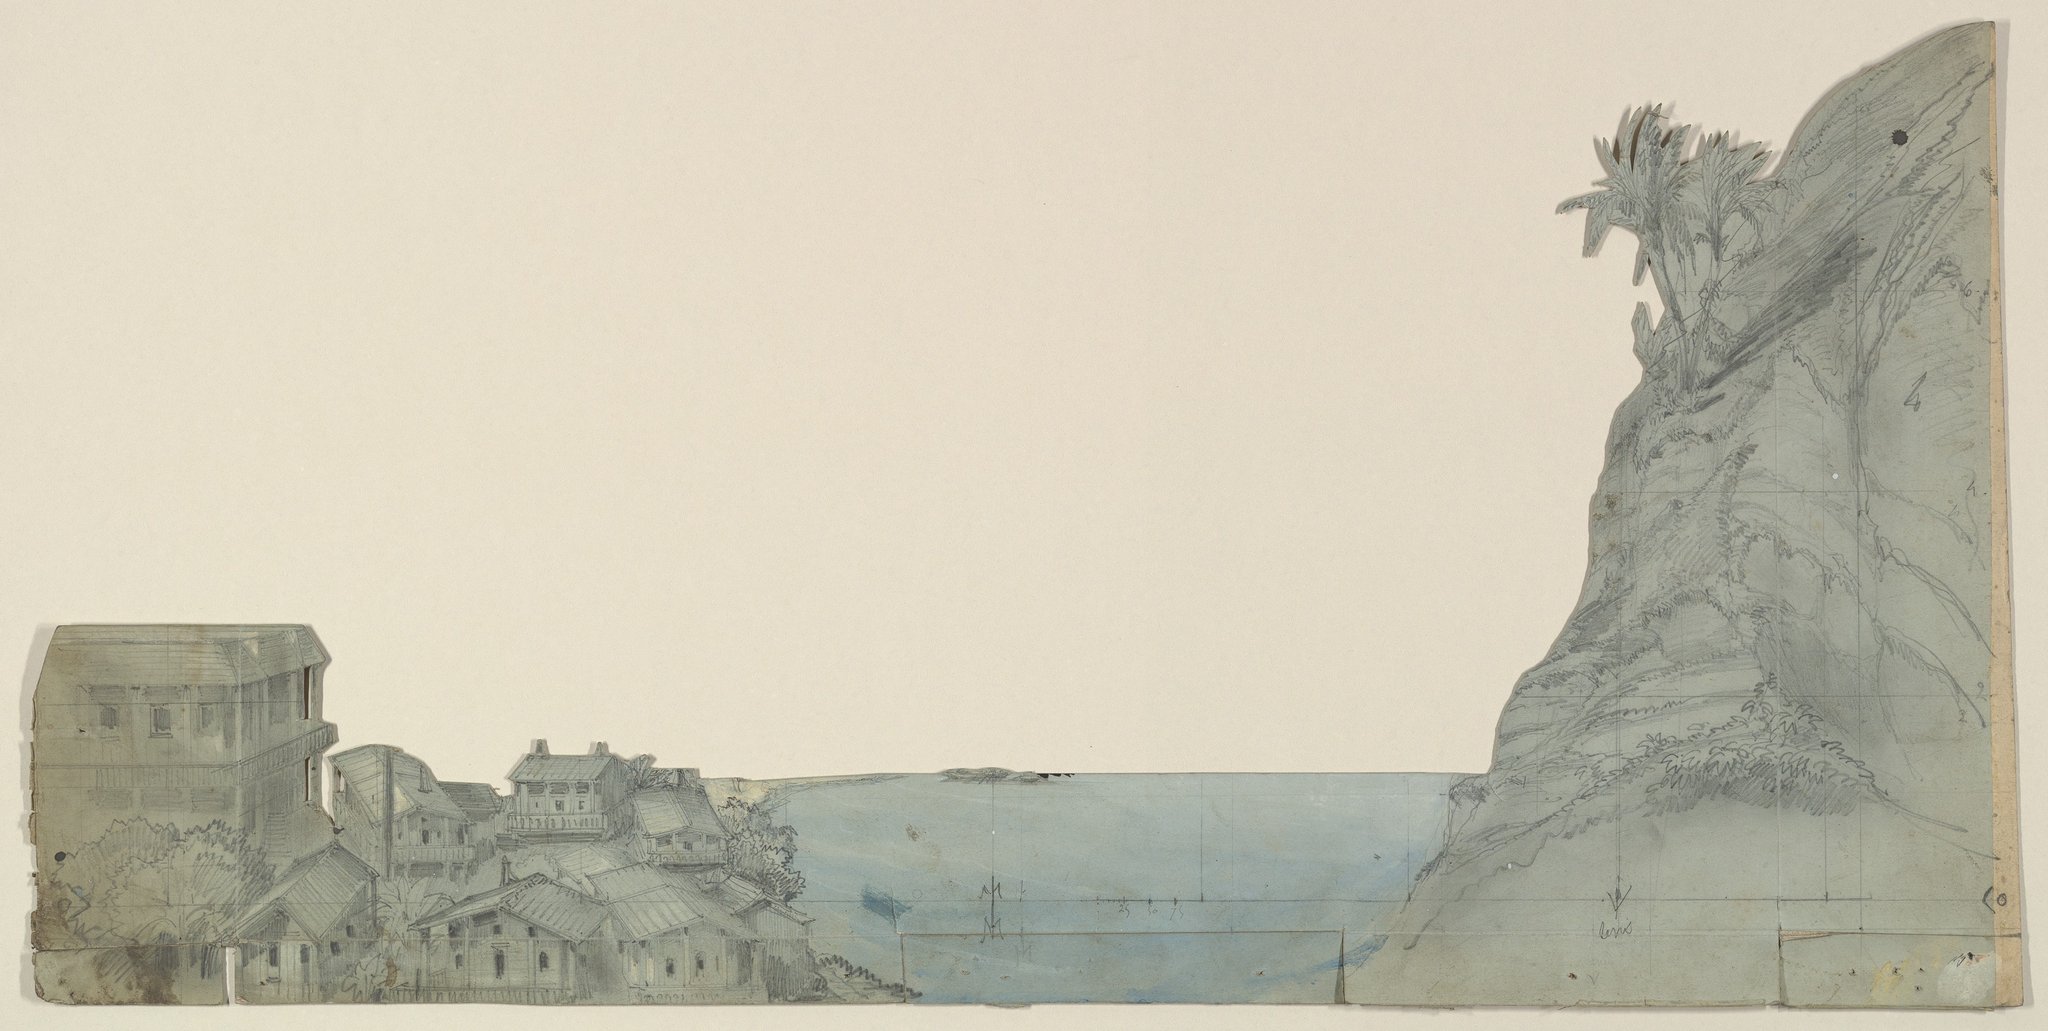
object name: drawing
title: Design for a Stage Set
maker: eugène cicéri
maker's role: artist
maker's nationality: french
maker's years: 1813-1890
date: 1830-1890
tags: buildings,hills,stage design